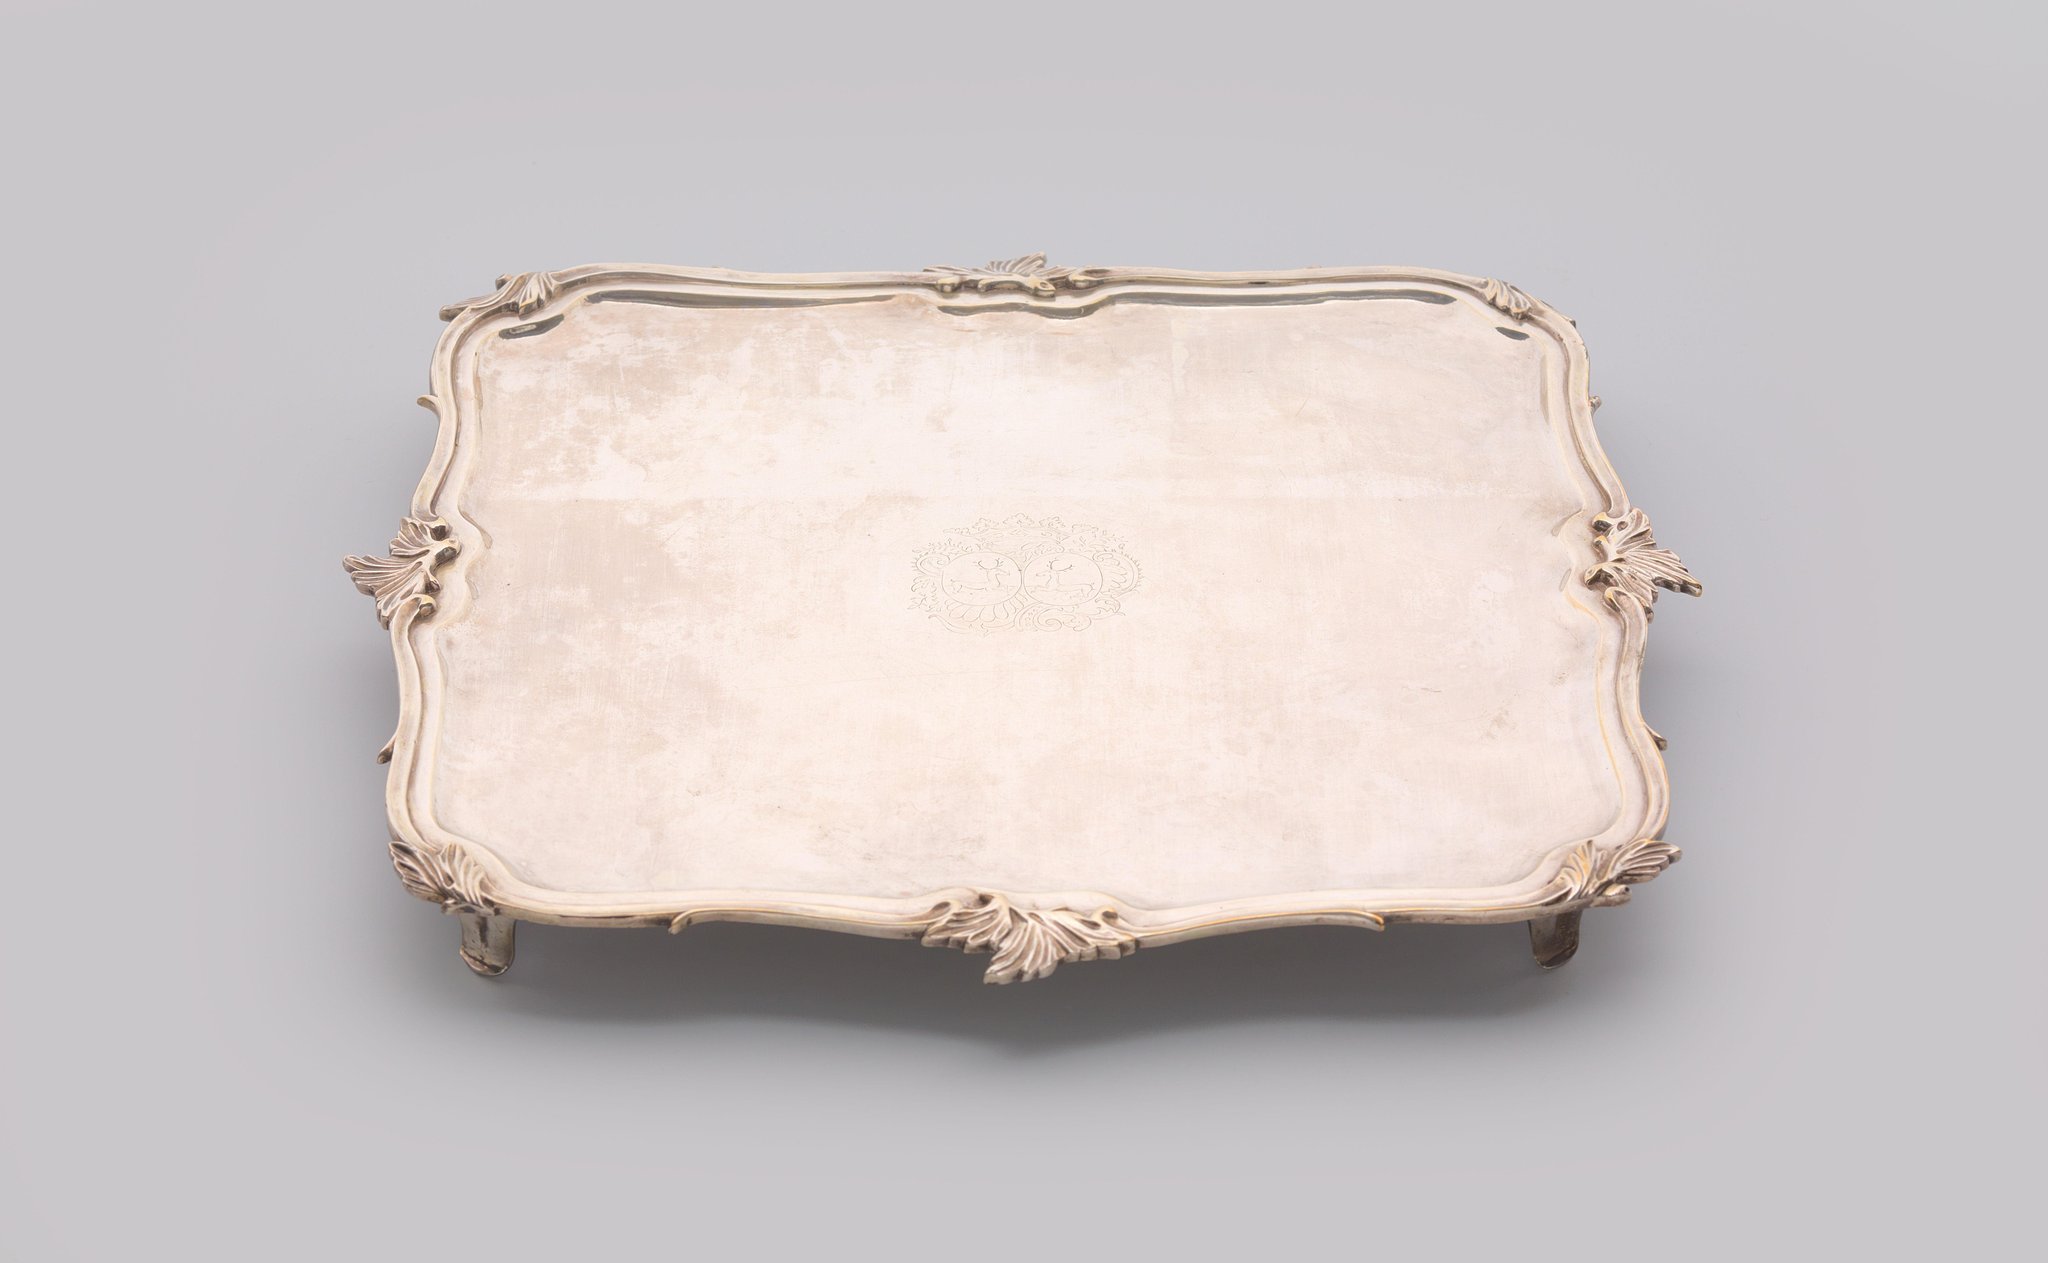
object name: salver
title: Presenteerblad van zilver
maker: johannes hallegraaf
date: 1763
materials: silver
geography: deventer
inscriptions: maker's mark: ‘IH (Ter Molen 1997, p. 203)’, date letter: ‘3P (Ter Molen 1997, p. 199)’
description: Vierkant presenteerblad van zilver, op 4 pootjes. Lodewijk XV. Omgeven door een flauw geschulpte, geappliqueerde rand. Op het blad een gegraveerd, gekroond wapen met herten.